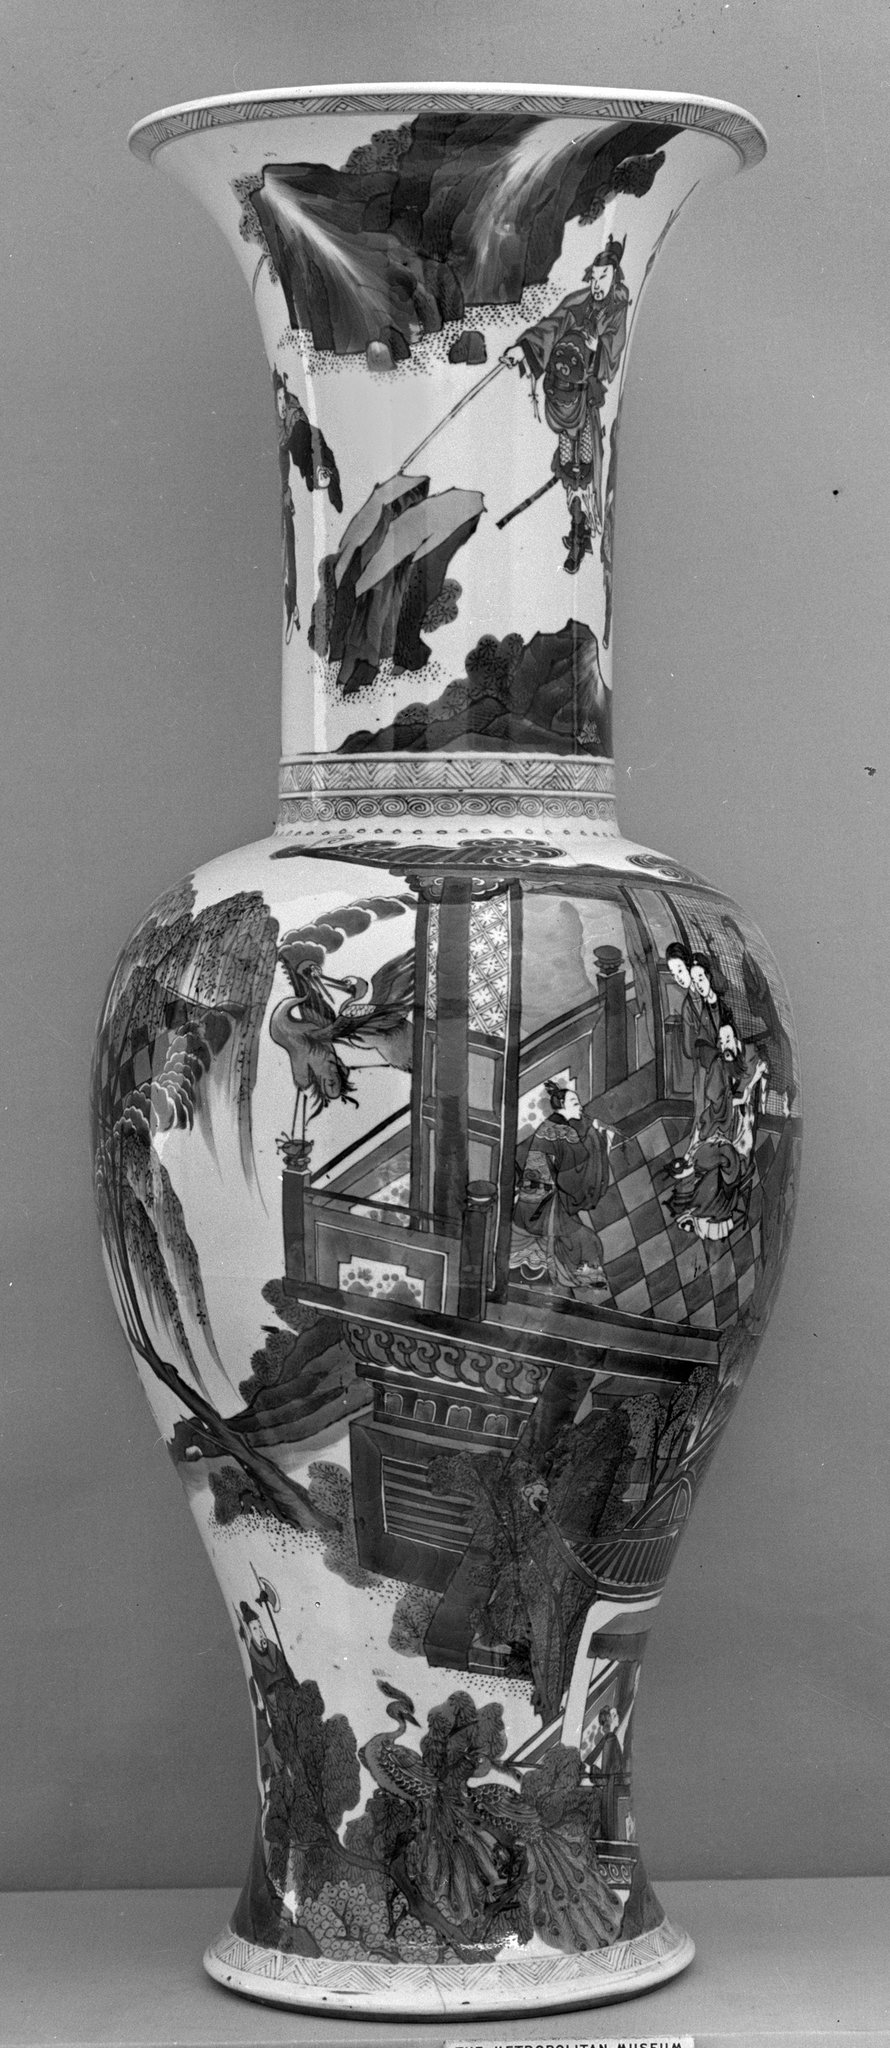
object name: vase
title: Vase with scenes from Romance of the Three Kingdoms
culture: chinese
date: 1662-1722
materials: cobalt, porcelain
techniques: painting, underglaze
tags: men,women,peacocks